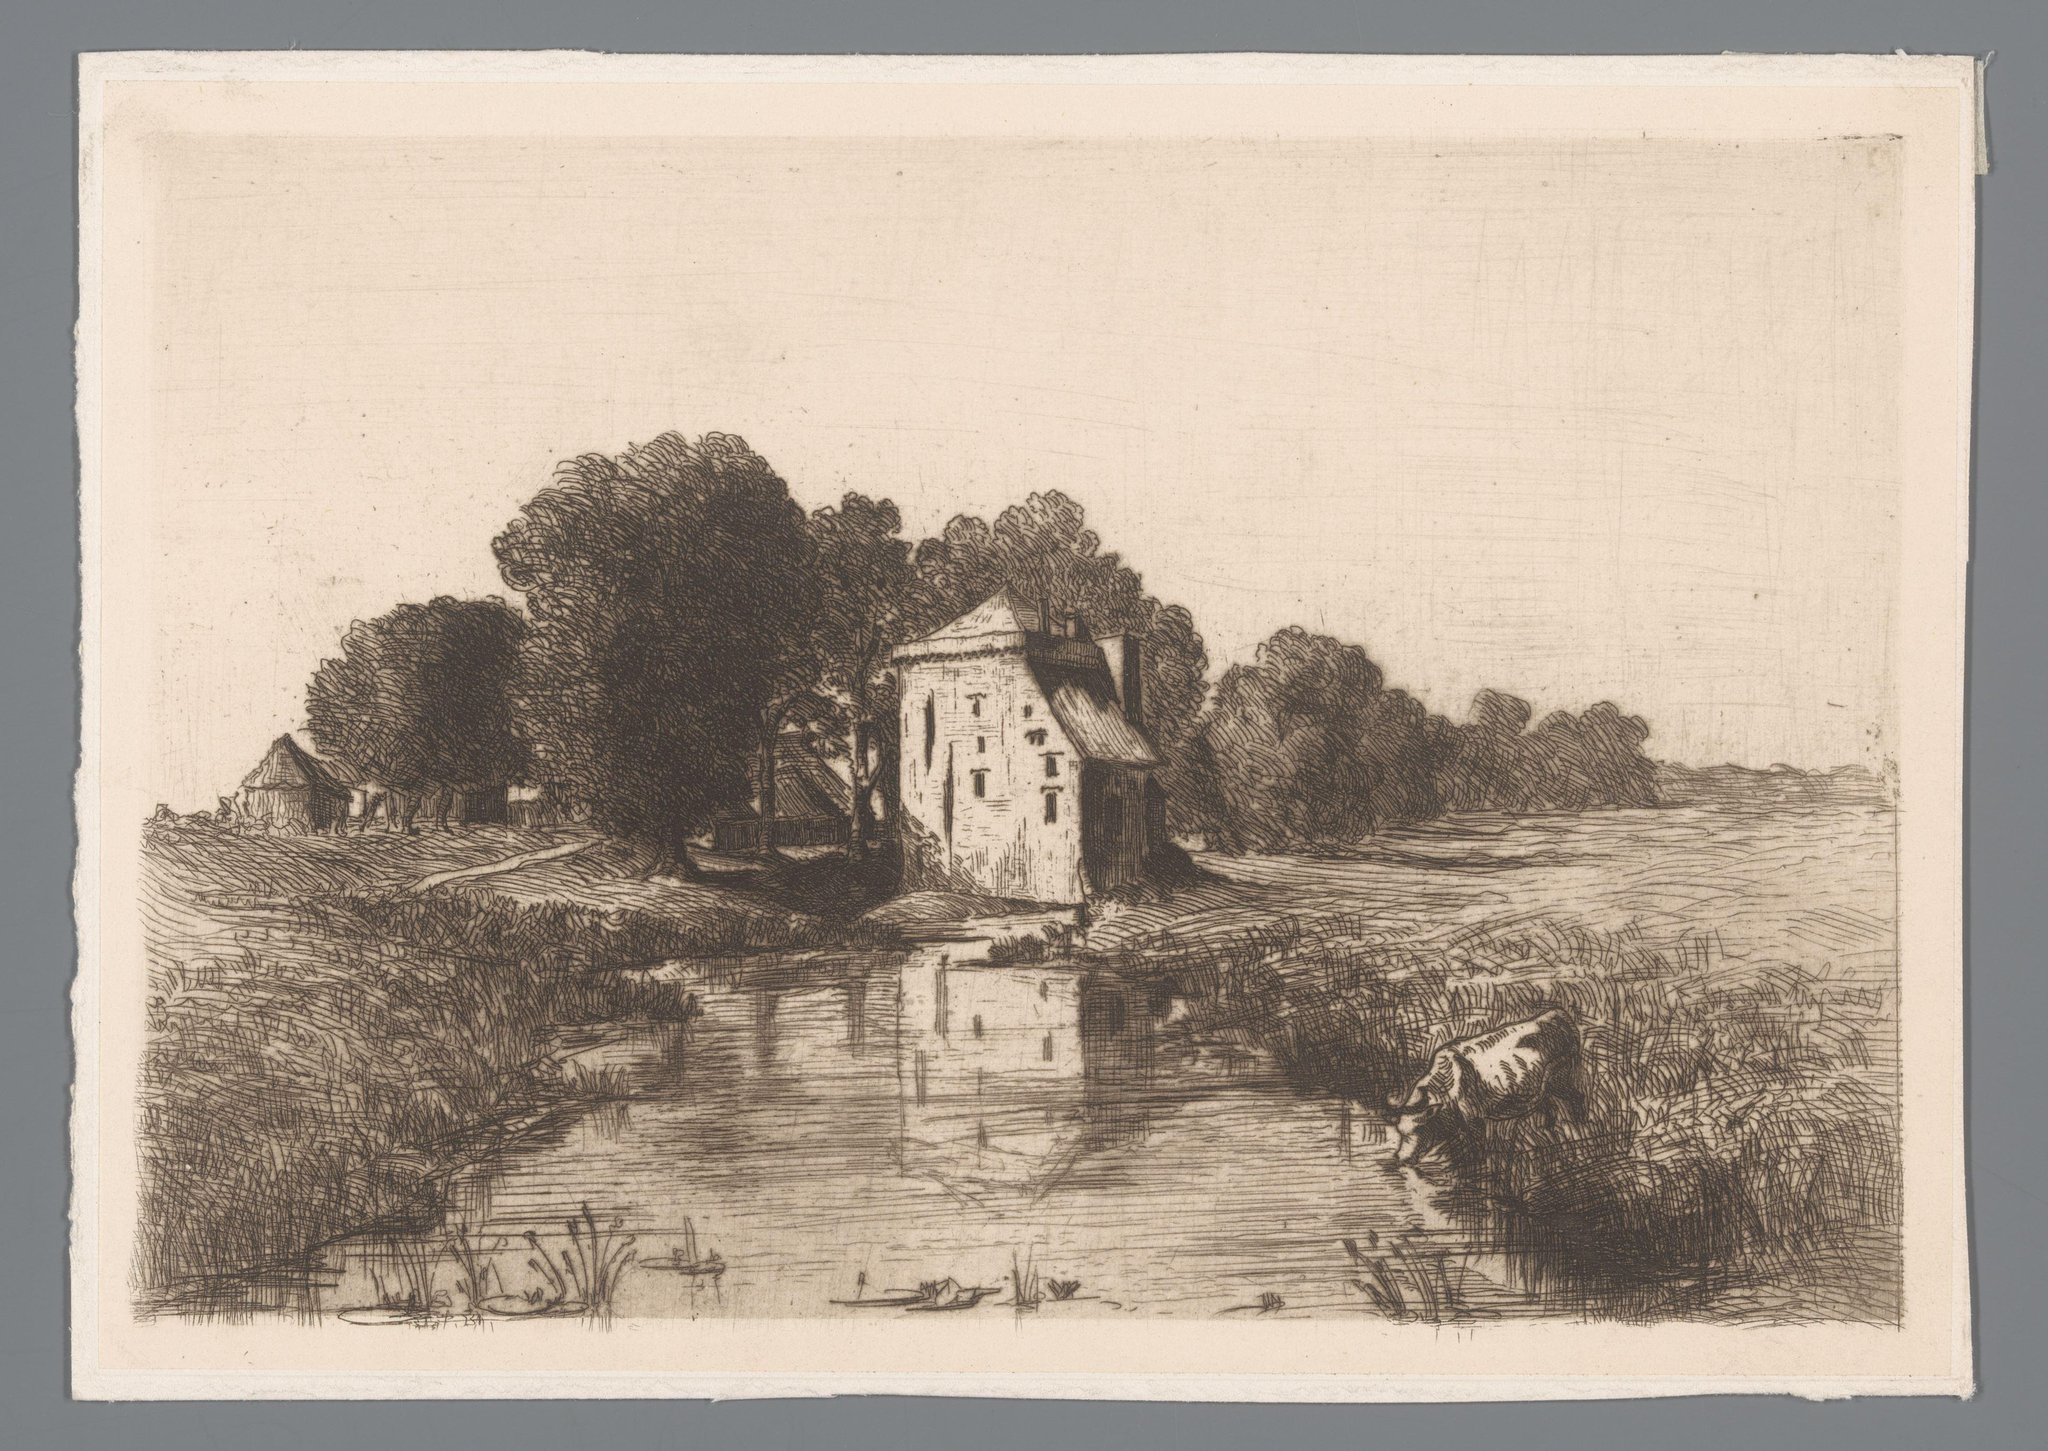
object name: print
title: Gezicht op de ruïne van Kasteel Nijenbeek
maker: jonkheer barthold willem floris van riemsdijk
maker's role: engineer, print maker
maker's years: 1850-1942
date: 1893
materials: paper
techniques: drypoint, intaglio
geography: netherlands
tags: cow, landscape with ruins, ruin of a dwelling, house, castle, etc.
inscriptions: collector's mark: Lugt 2228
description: Gezicht op kasteel Nijenbeek, aan de oever van de Voorsterbeek (een oude bedding van de IJssel). Uit de beek drinkt een koe. Het kasteel wordt ook wel het Hooge Huis genoemd.